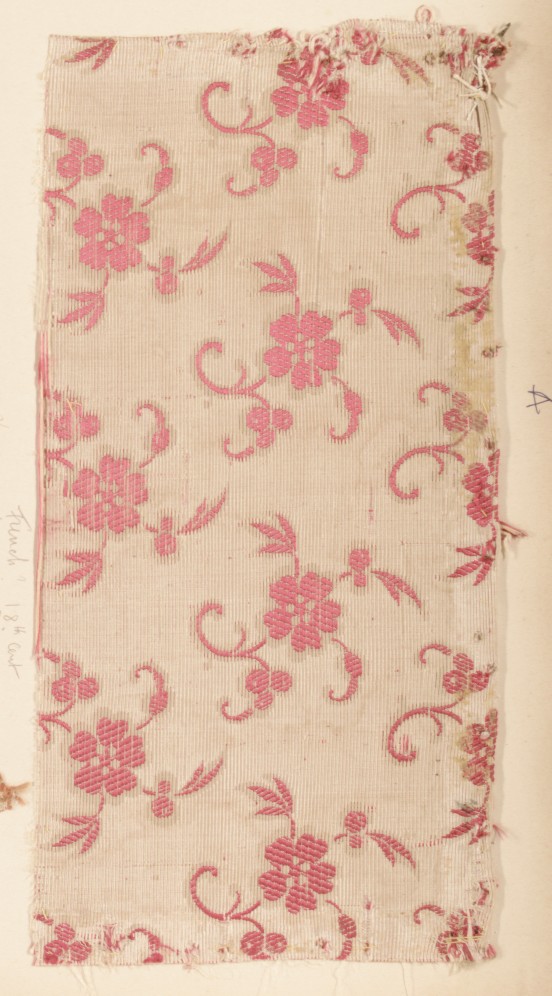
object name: fragment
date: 1701-1800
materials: silk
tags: flowers,leaves